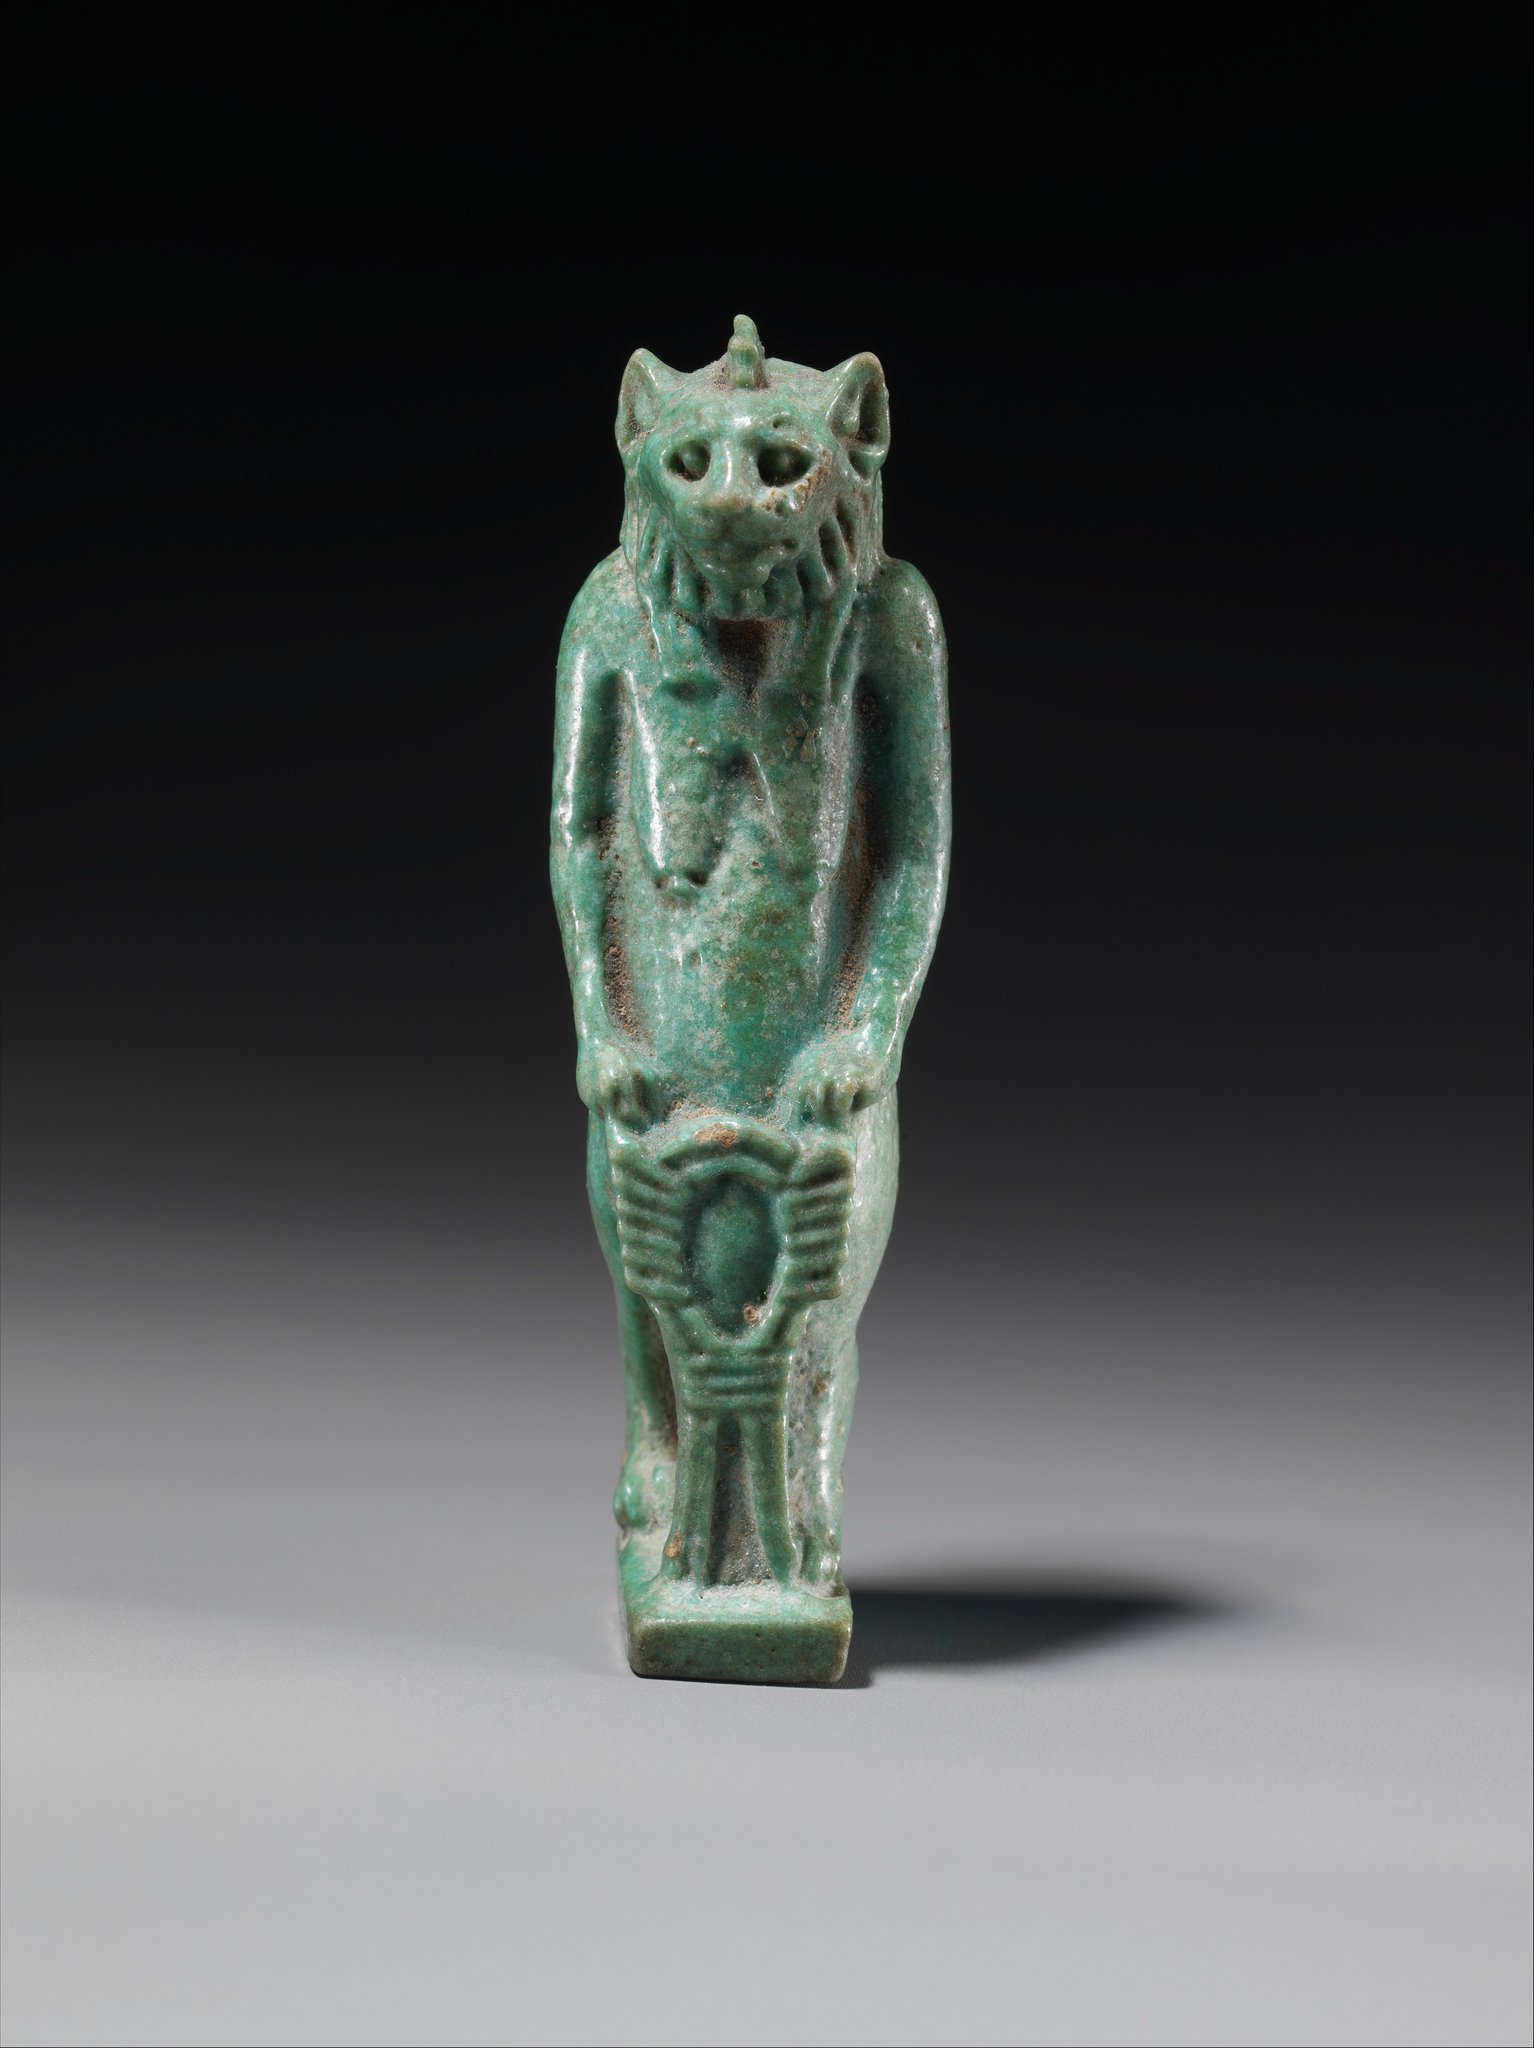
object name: amulet, taweret with lion head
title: The Goddess Taweret with a Feline Head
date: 664-332 BCE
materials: faience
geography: egypt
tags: taweret